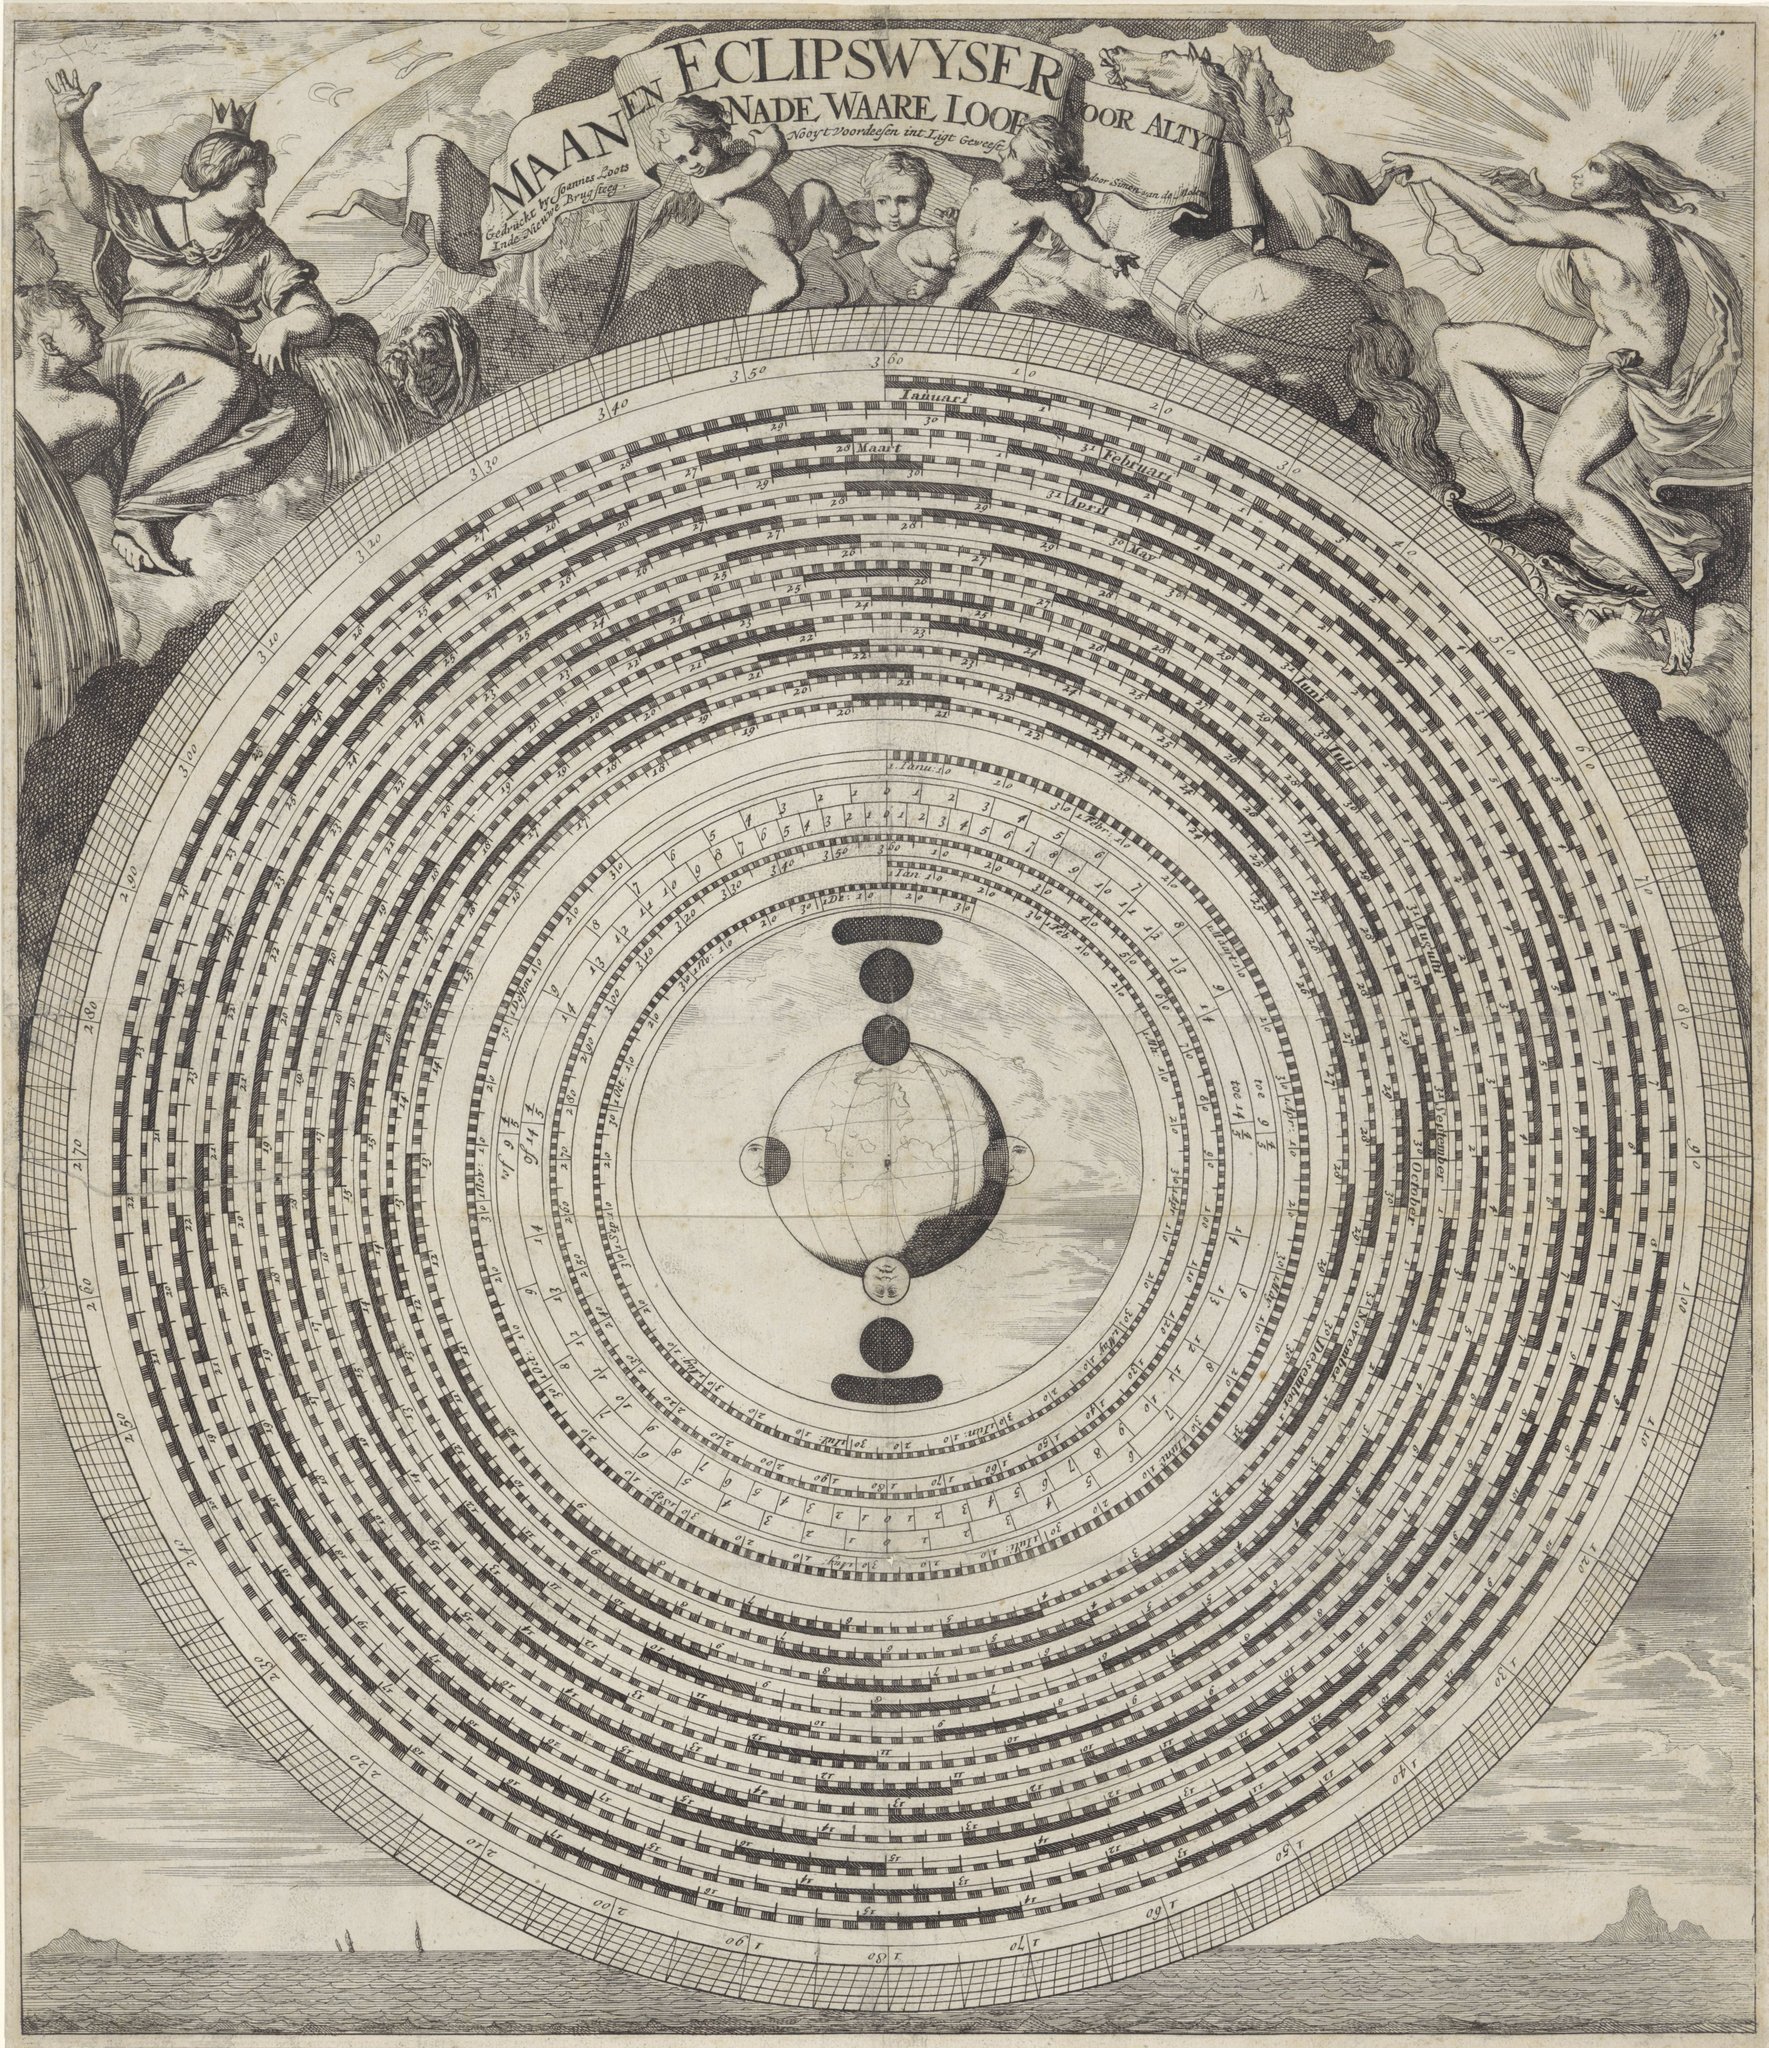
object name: print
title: Maan- en eclipswijzer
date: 1695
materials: paper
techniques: etching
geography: northern netherlands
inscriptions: collector's mark: Lugt 2228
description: Cirkelvormige aanduiding van de stand van de maan op de verschillende dagen van het jaar.